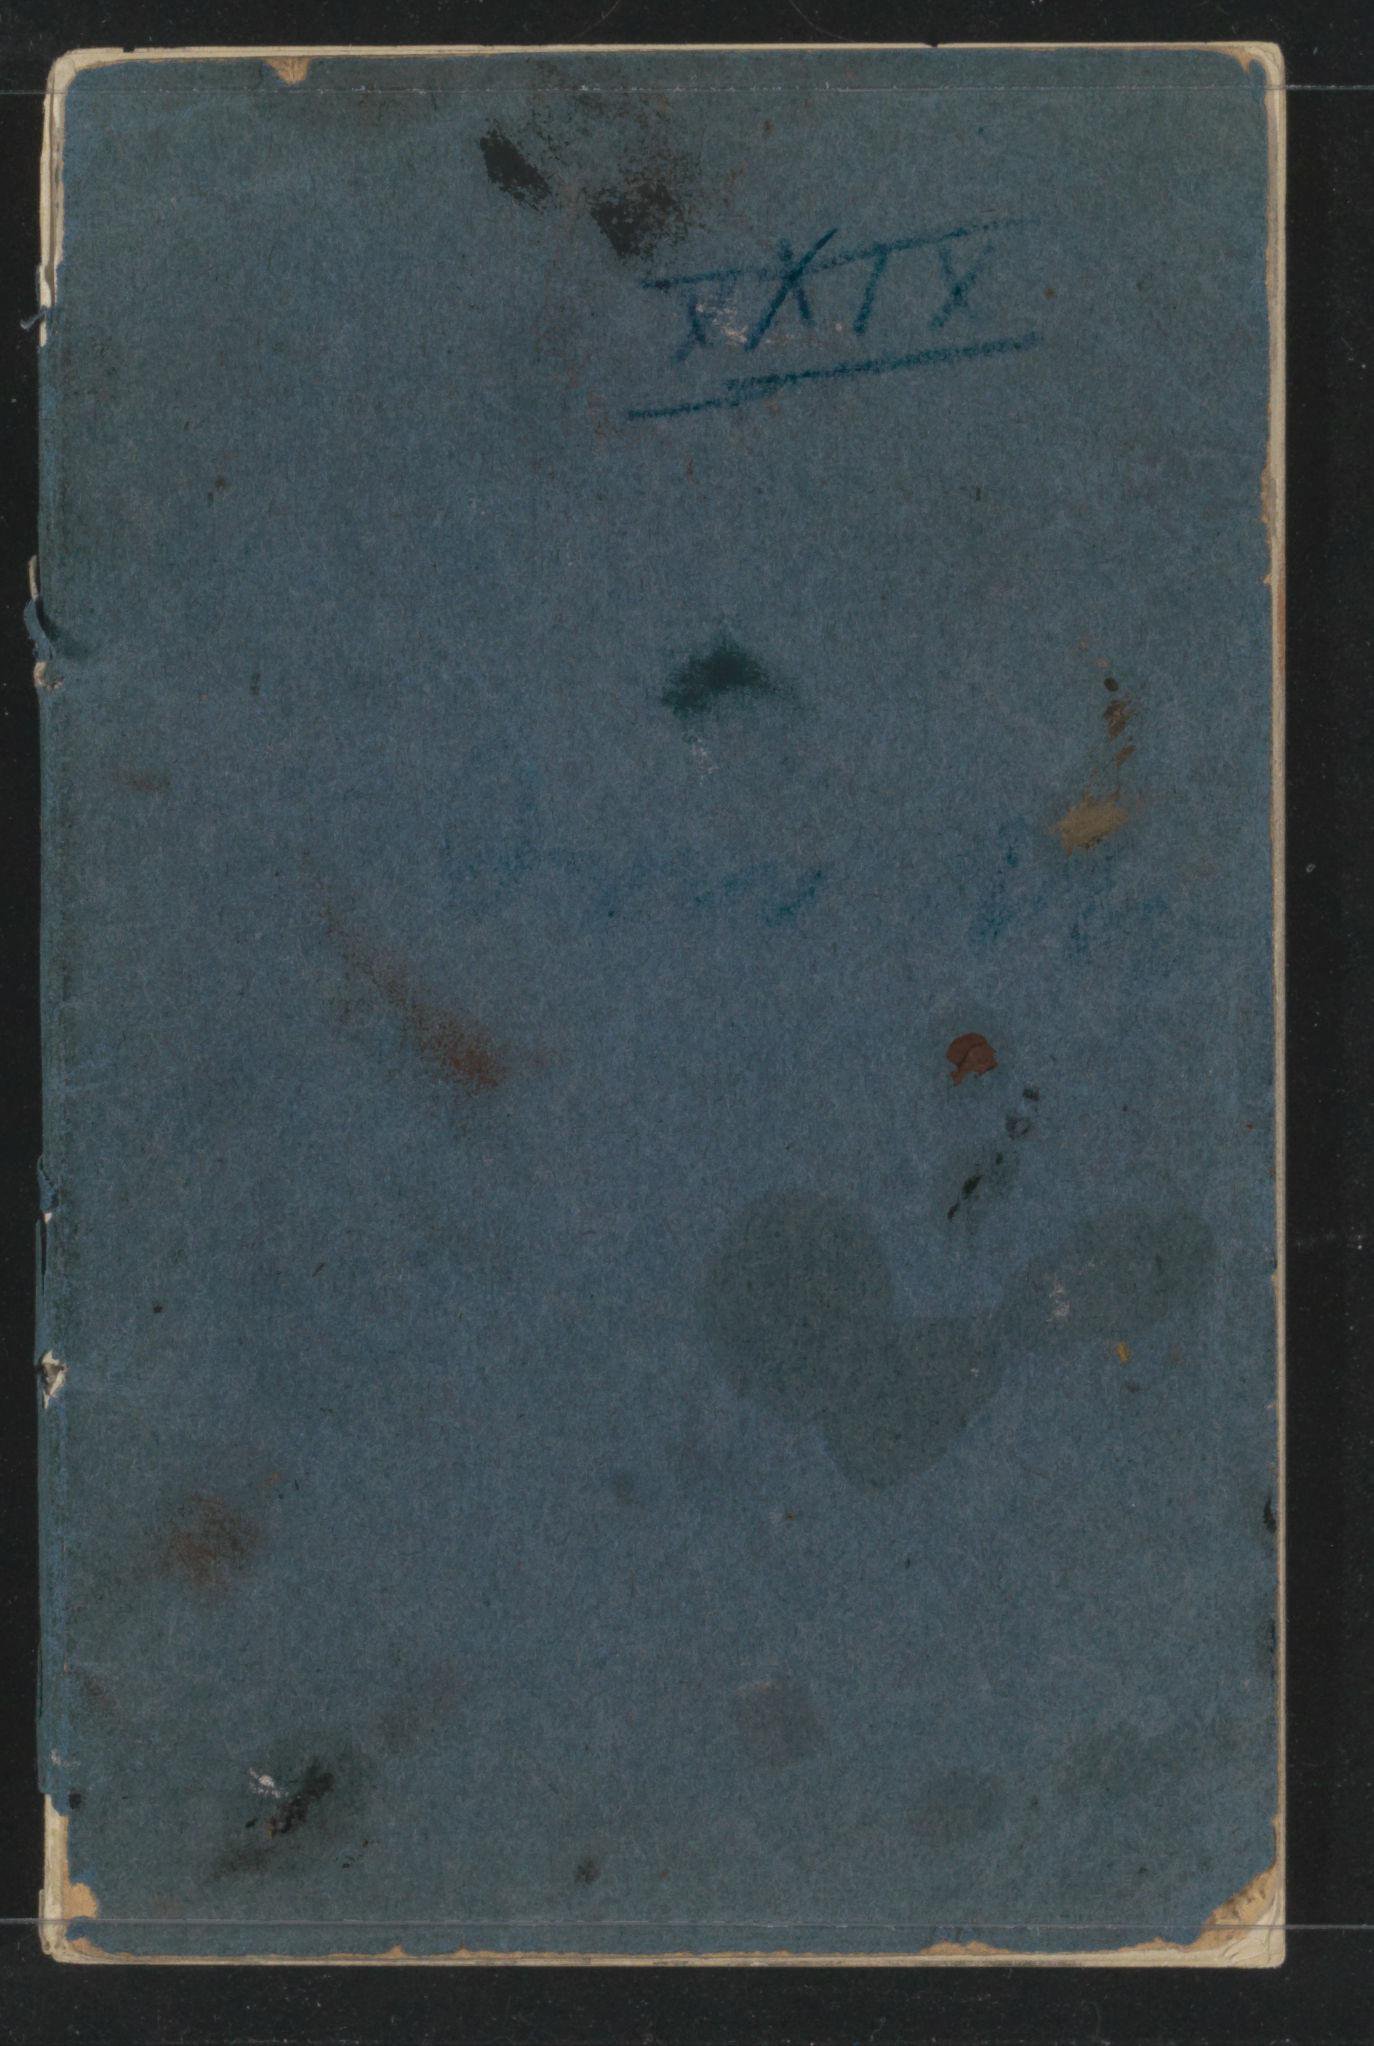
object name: sketchbook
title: Schetsboek XXIX met 44 pagina's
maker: isaac israels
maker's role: draughtsman, painter, print maker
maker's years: 1865-1934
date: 1875-1934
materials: chalk, paper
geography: amsterdam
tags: clouds, street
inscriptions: collector's mark: Lugt 2228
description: Schetsboek nr. XXIX bestaande uit 44 pagina's met straatgezichten, groepen mensen en een wolkenstudie.